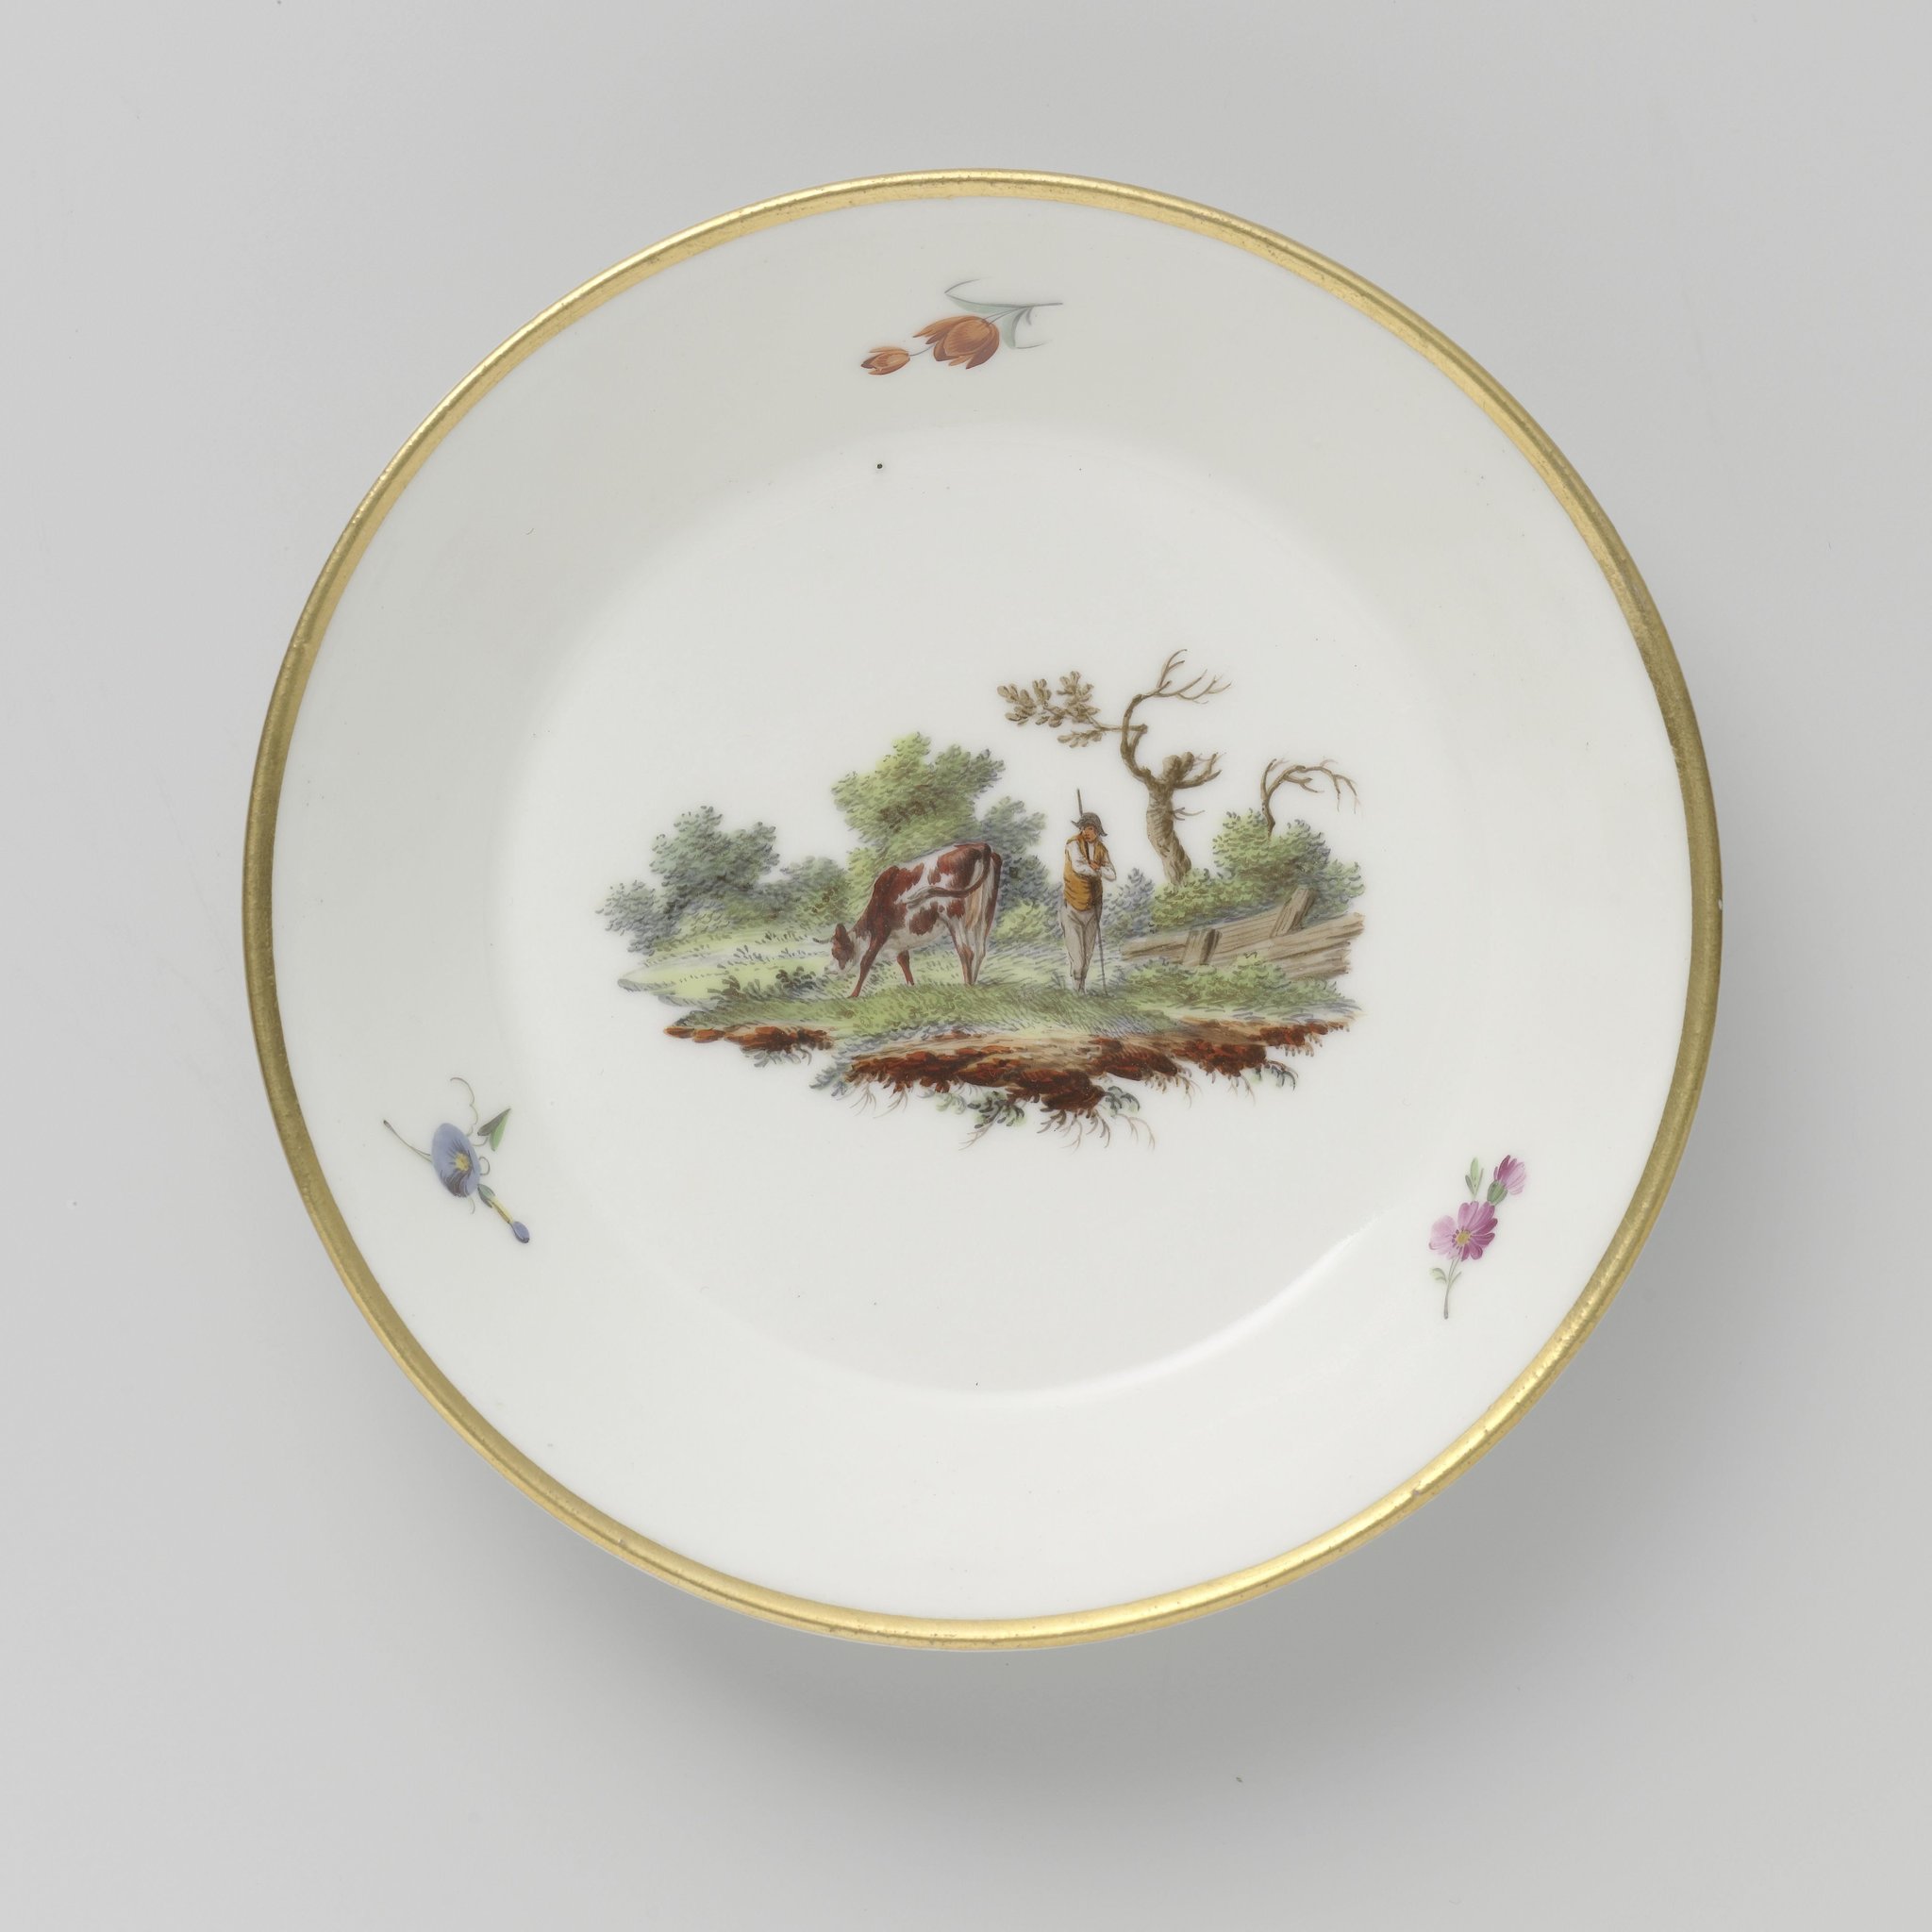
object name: tea service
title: Schotel, beschilderd met een landschap met vee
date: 1809-1814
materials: porcelain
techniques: painted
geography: nieuwer-amstel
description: Schotel, beschilderd met landschap met vee. Gemerkt: Amstel in blauw.